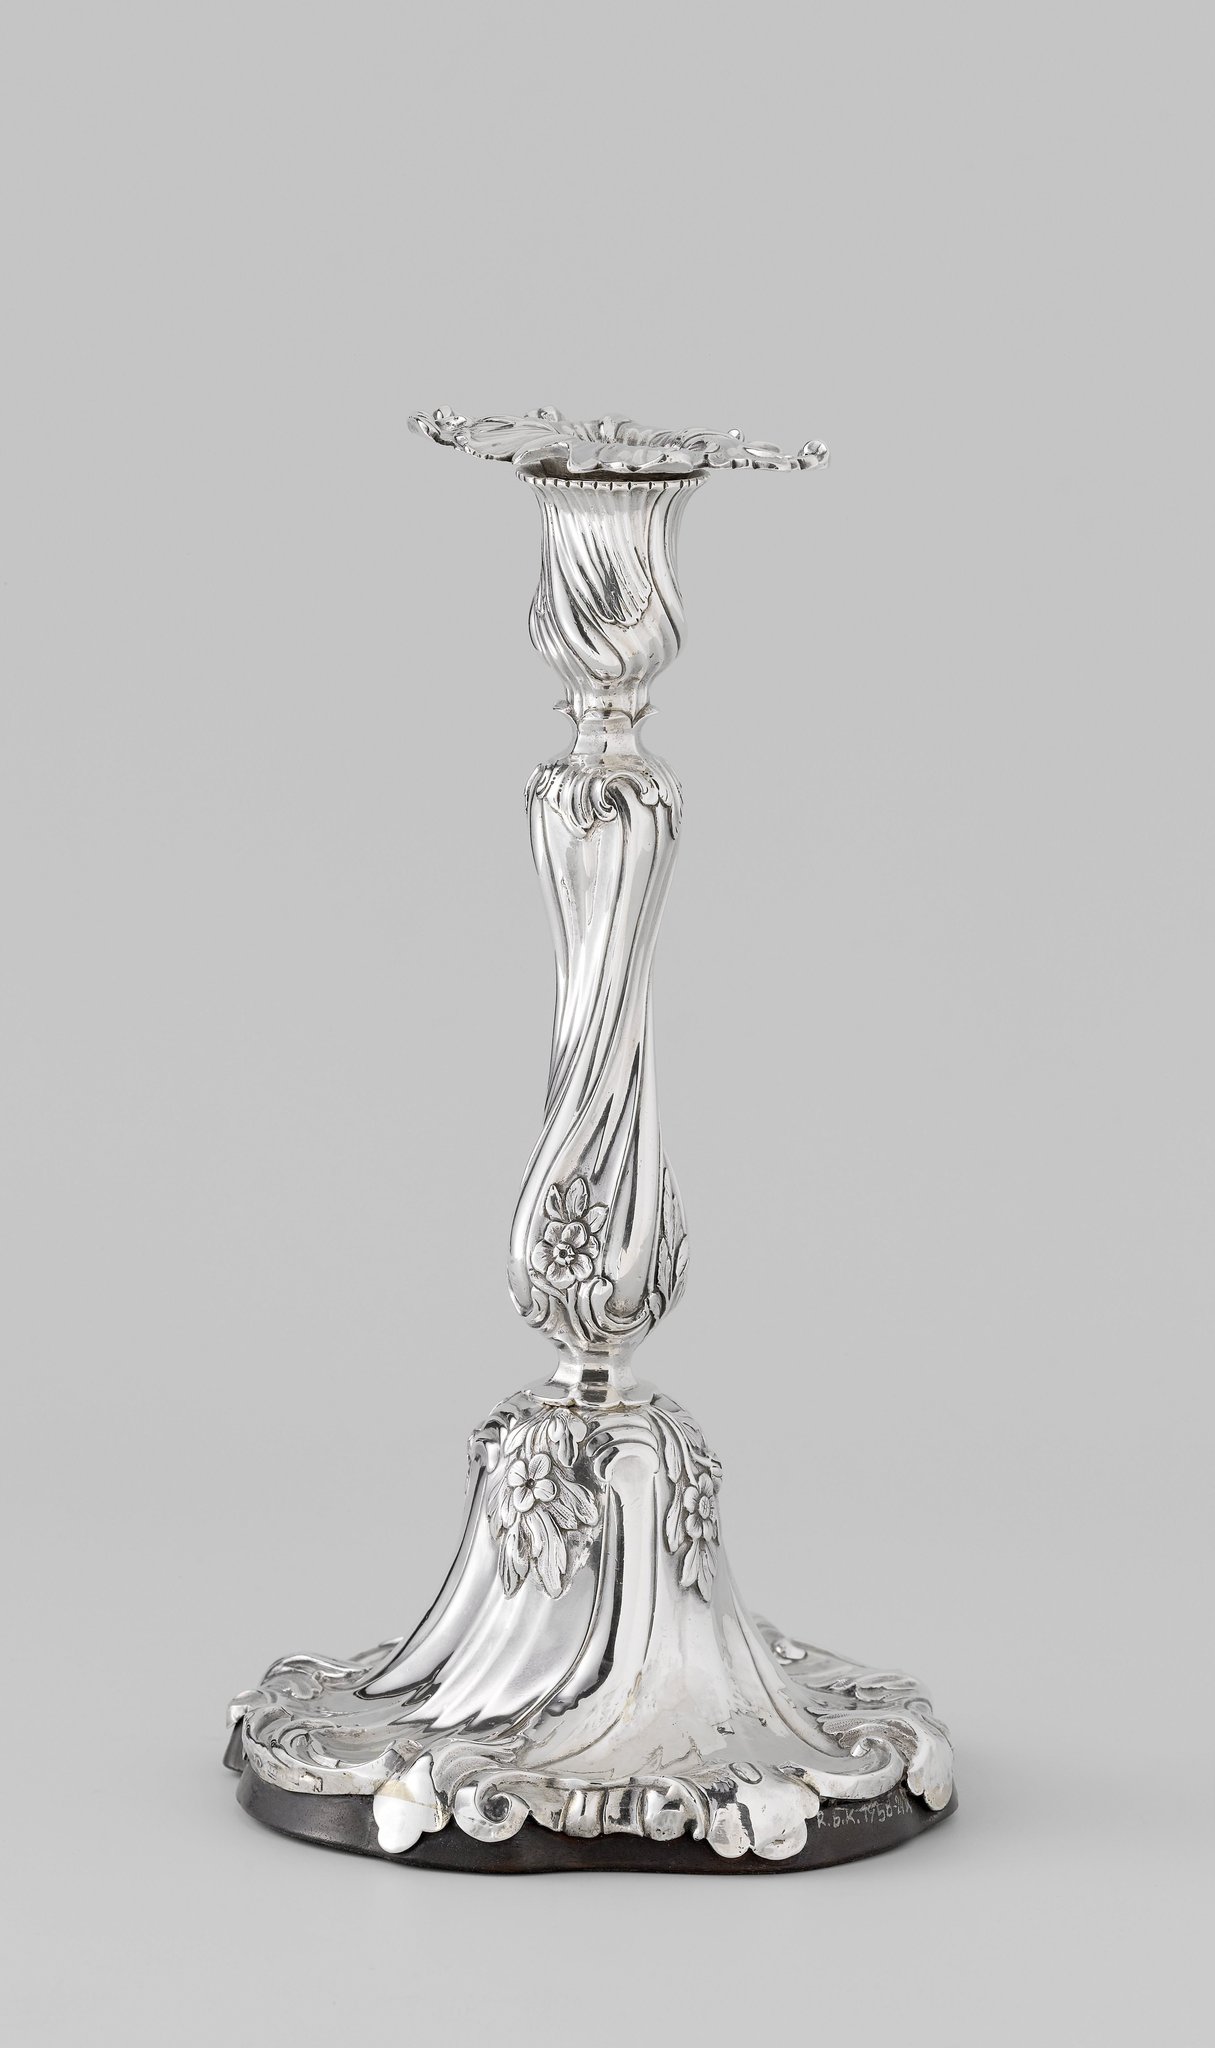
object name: candlestick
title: Kandelaar van gegoten zilver met klokvormige voet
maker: johannes schiotling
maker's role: silversmith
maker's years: 1730-1799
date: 1766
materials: silver, wood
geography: amsterdam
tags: ornament derived from plant forms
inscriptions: : ‘Z II (verantwoordelijkheidstekens, nr. NN091)’, maker's mark, town mark, date letter: ‘G’, alloy mark, inscription: ‘HDR’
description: Four candlesticks. Silver. Amsterdam, 1766, by Johannes Schiotling.